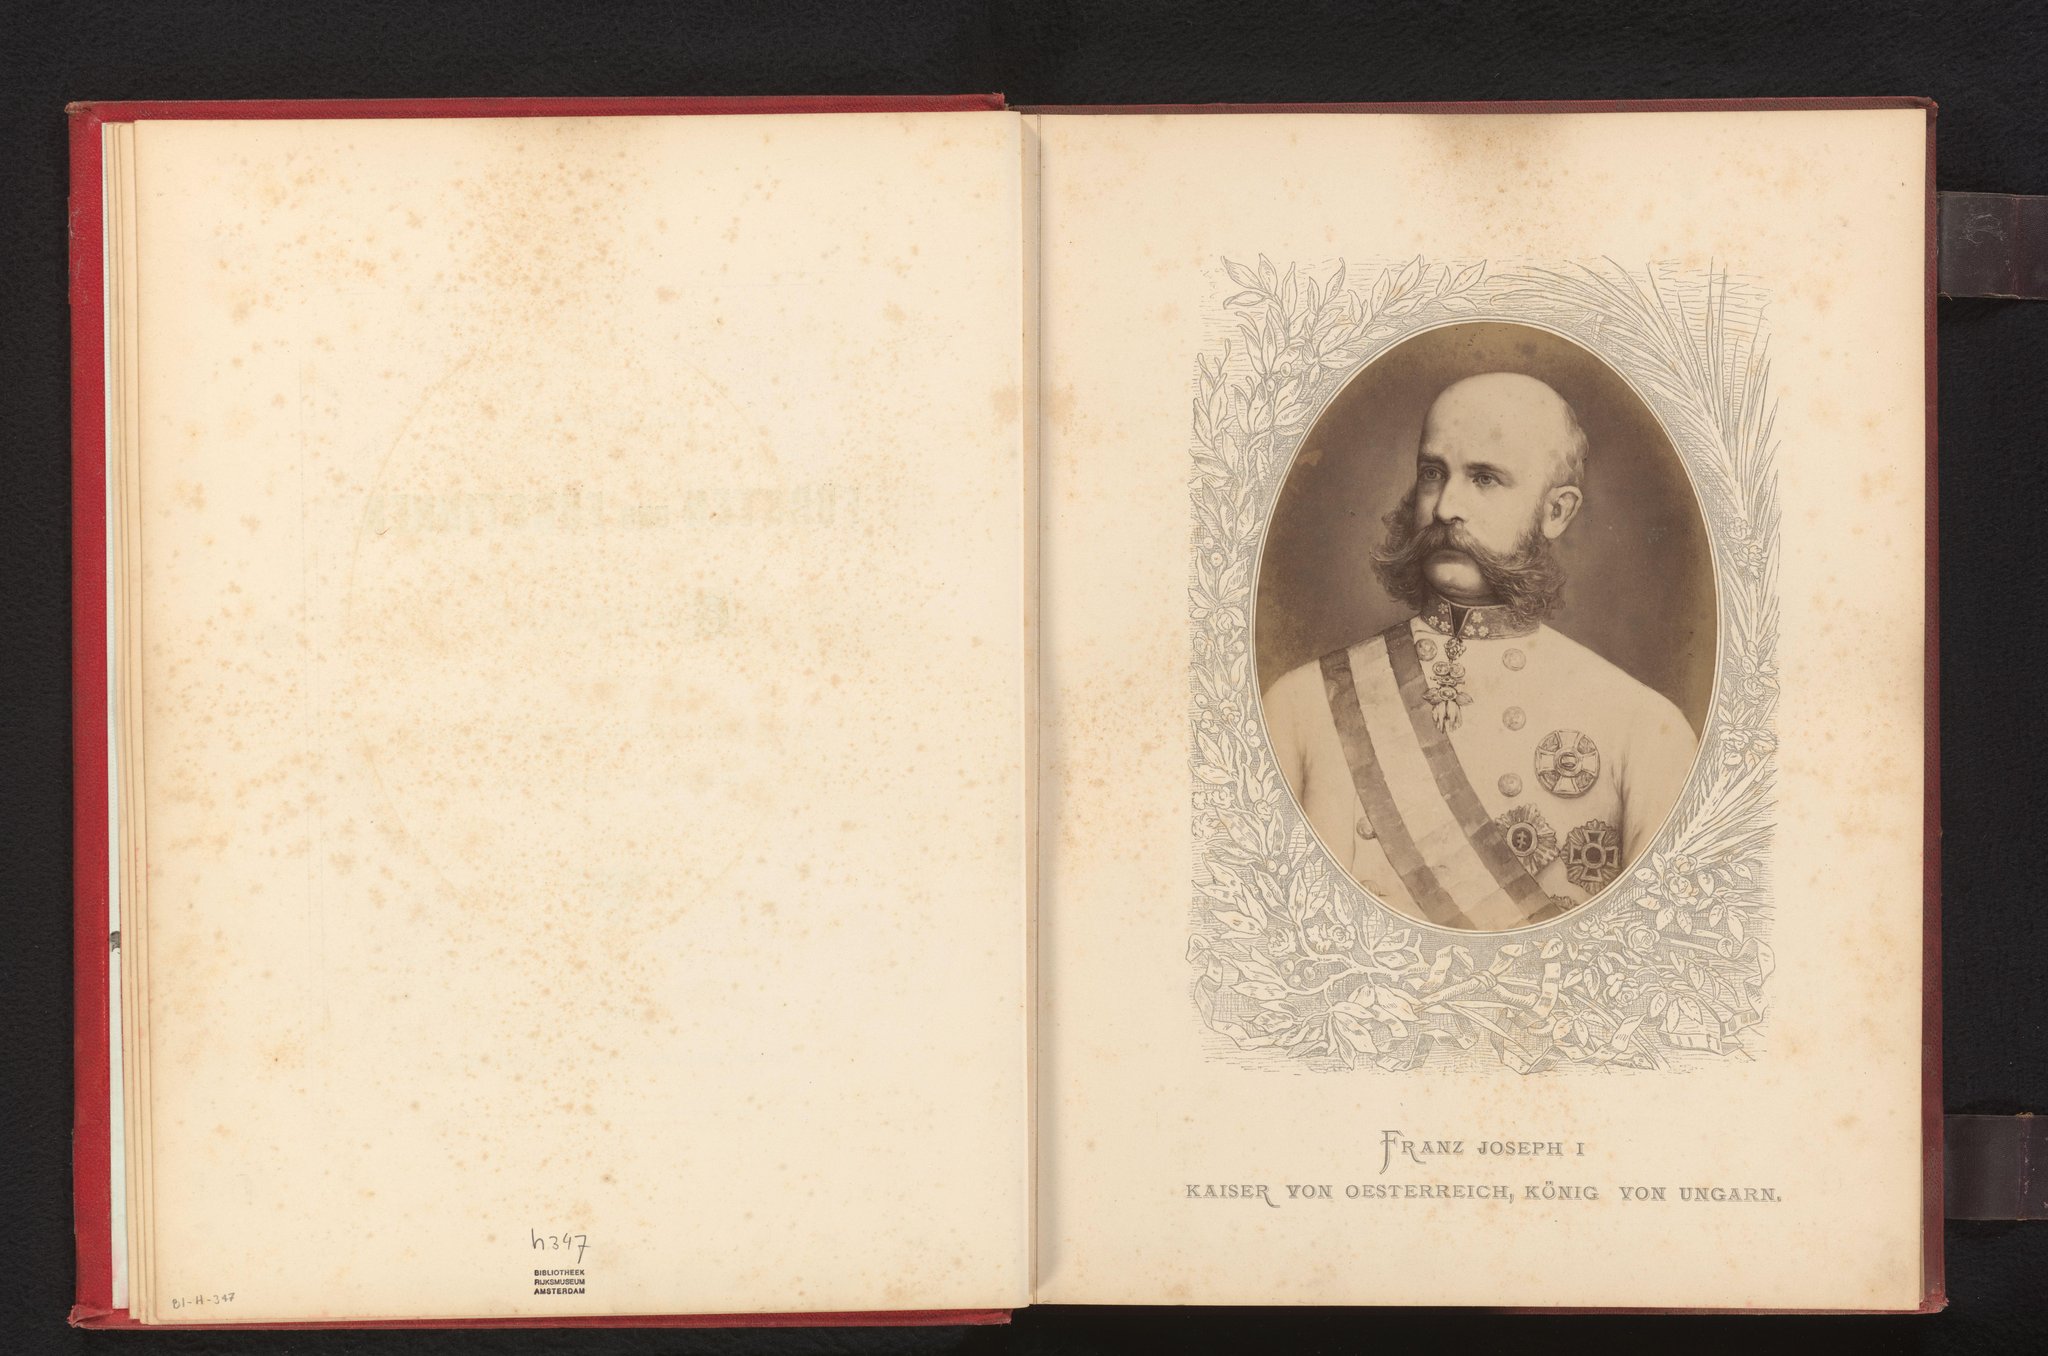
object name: reproduction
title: Franz Joseph I, Kaiser von Oesterreich, König von Ungarn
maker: Anonymous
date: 1875-1880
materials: paper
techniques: albumen print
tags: vienna, historical persons, emperor